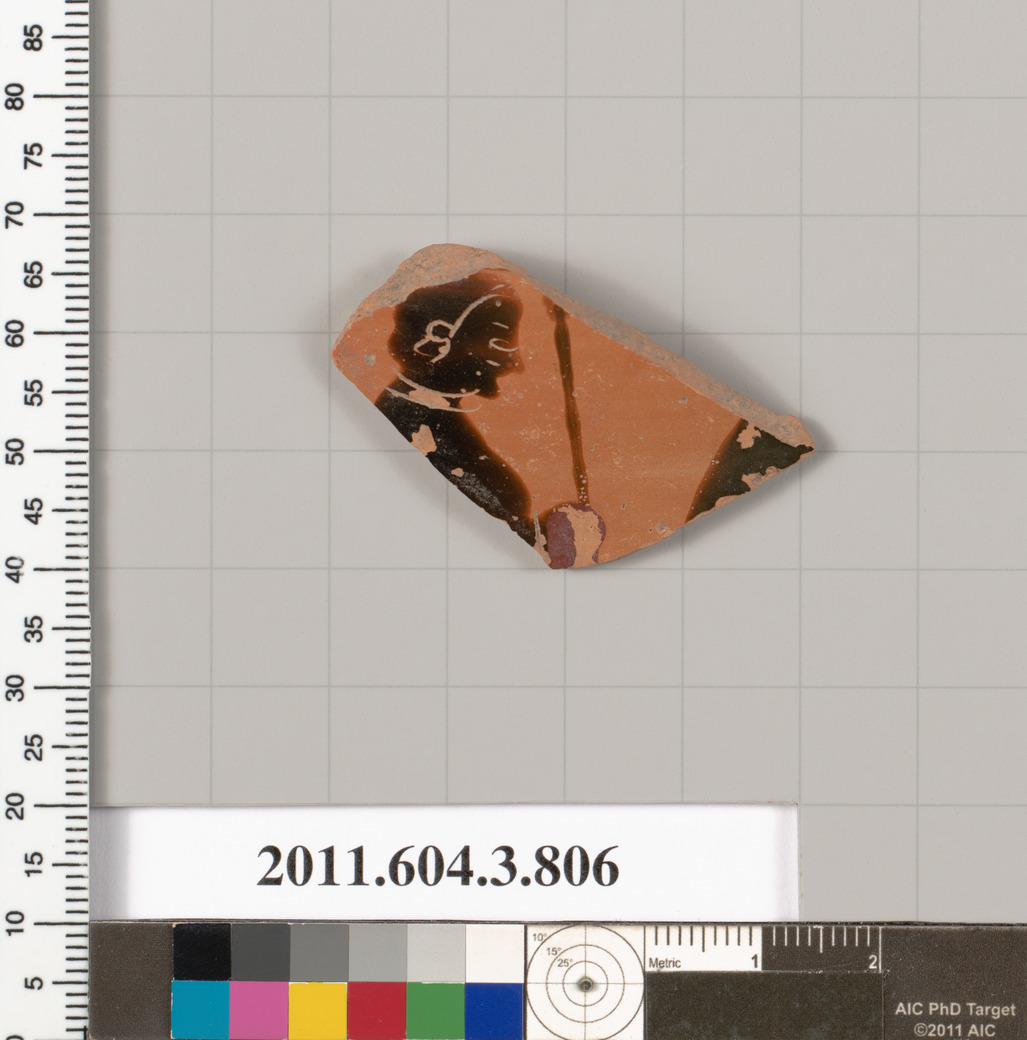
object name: lekythos fragment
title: Terracotta fragment of a lekythos (oil flask)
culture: greek, attic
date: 550-526 BCE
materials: terracotta